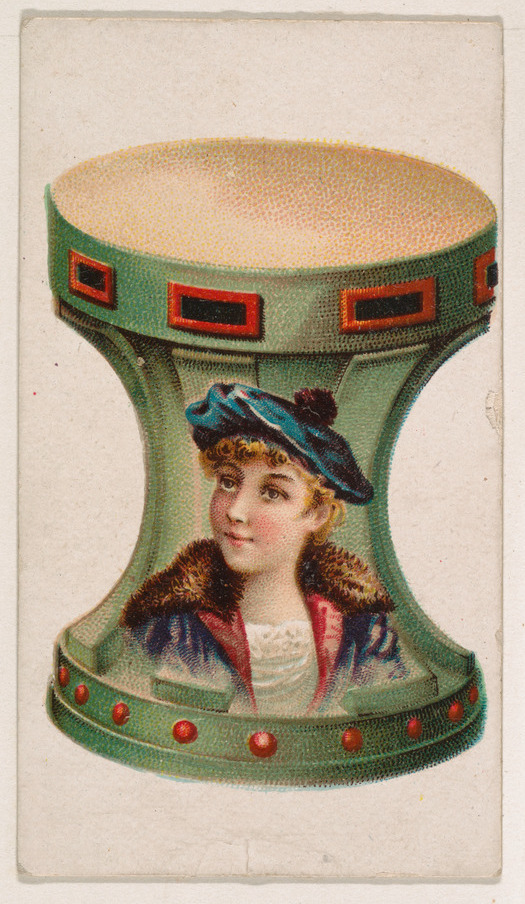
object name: print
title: Capstan, from the Novelties series (N228, Type 5) issued by Kinney Bros.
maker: kinney brothers tobacco company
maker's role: publisher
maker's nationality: american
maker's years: 1869-2011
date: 1889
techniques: color lithograph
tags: women